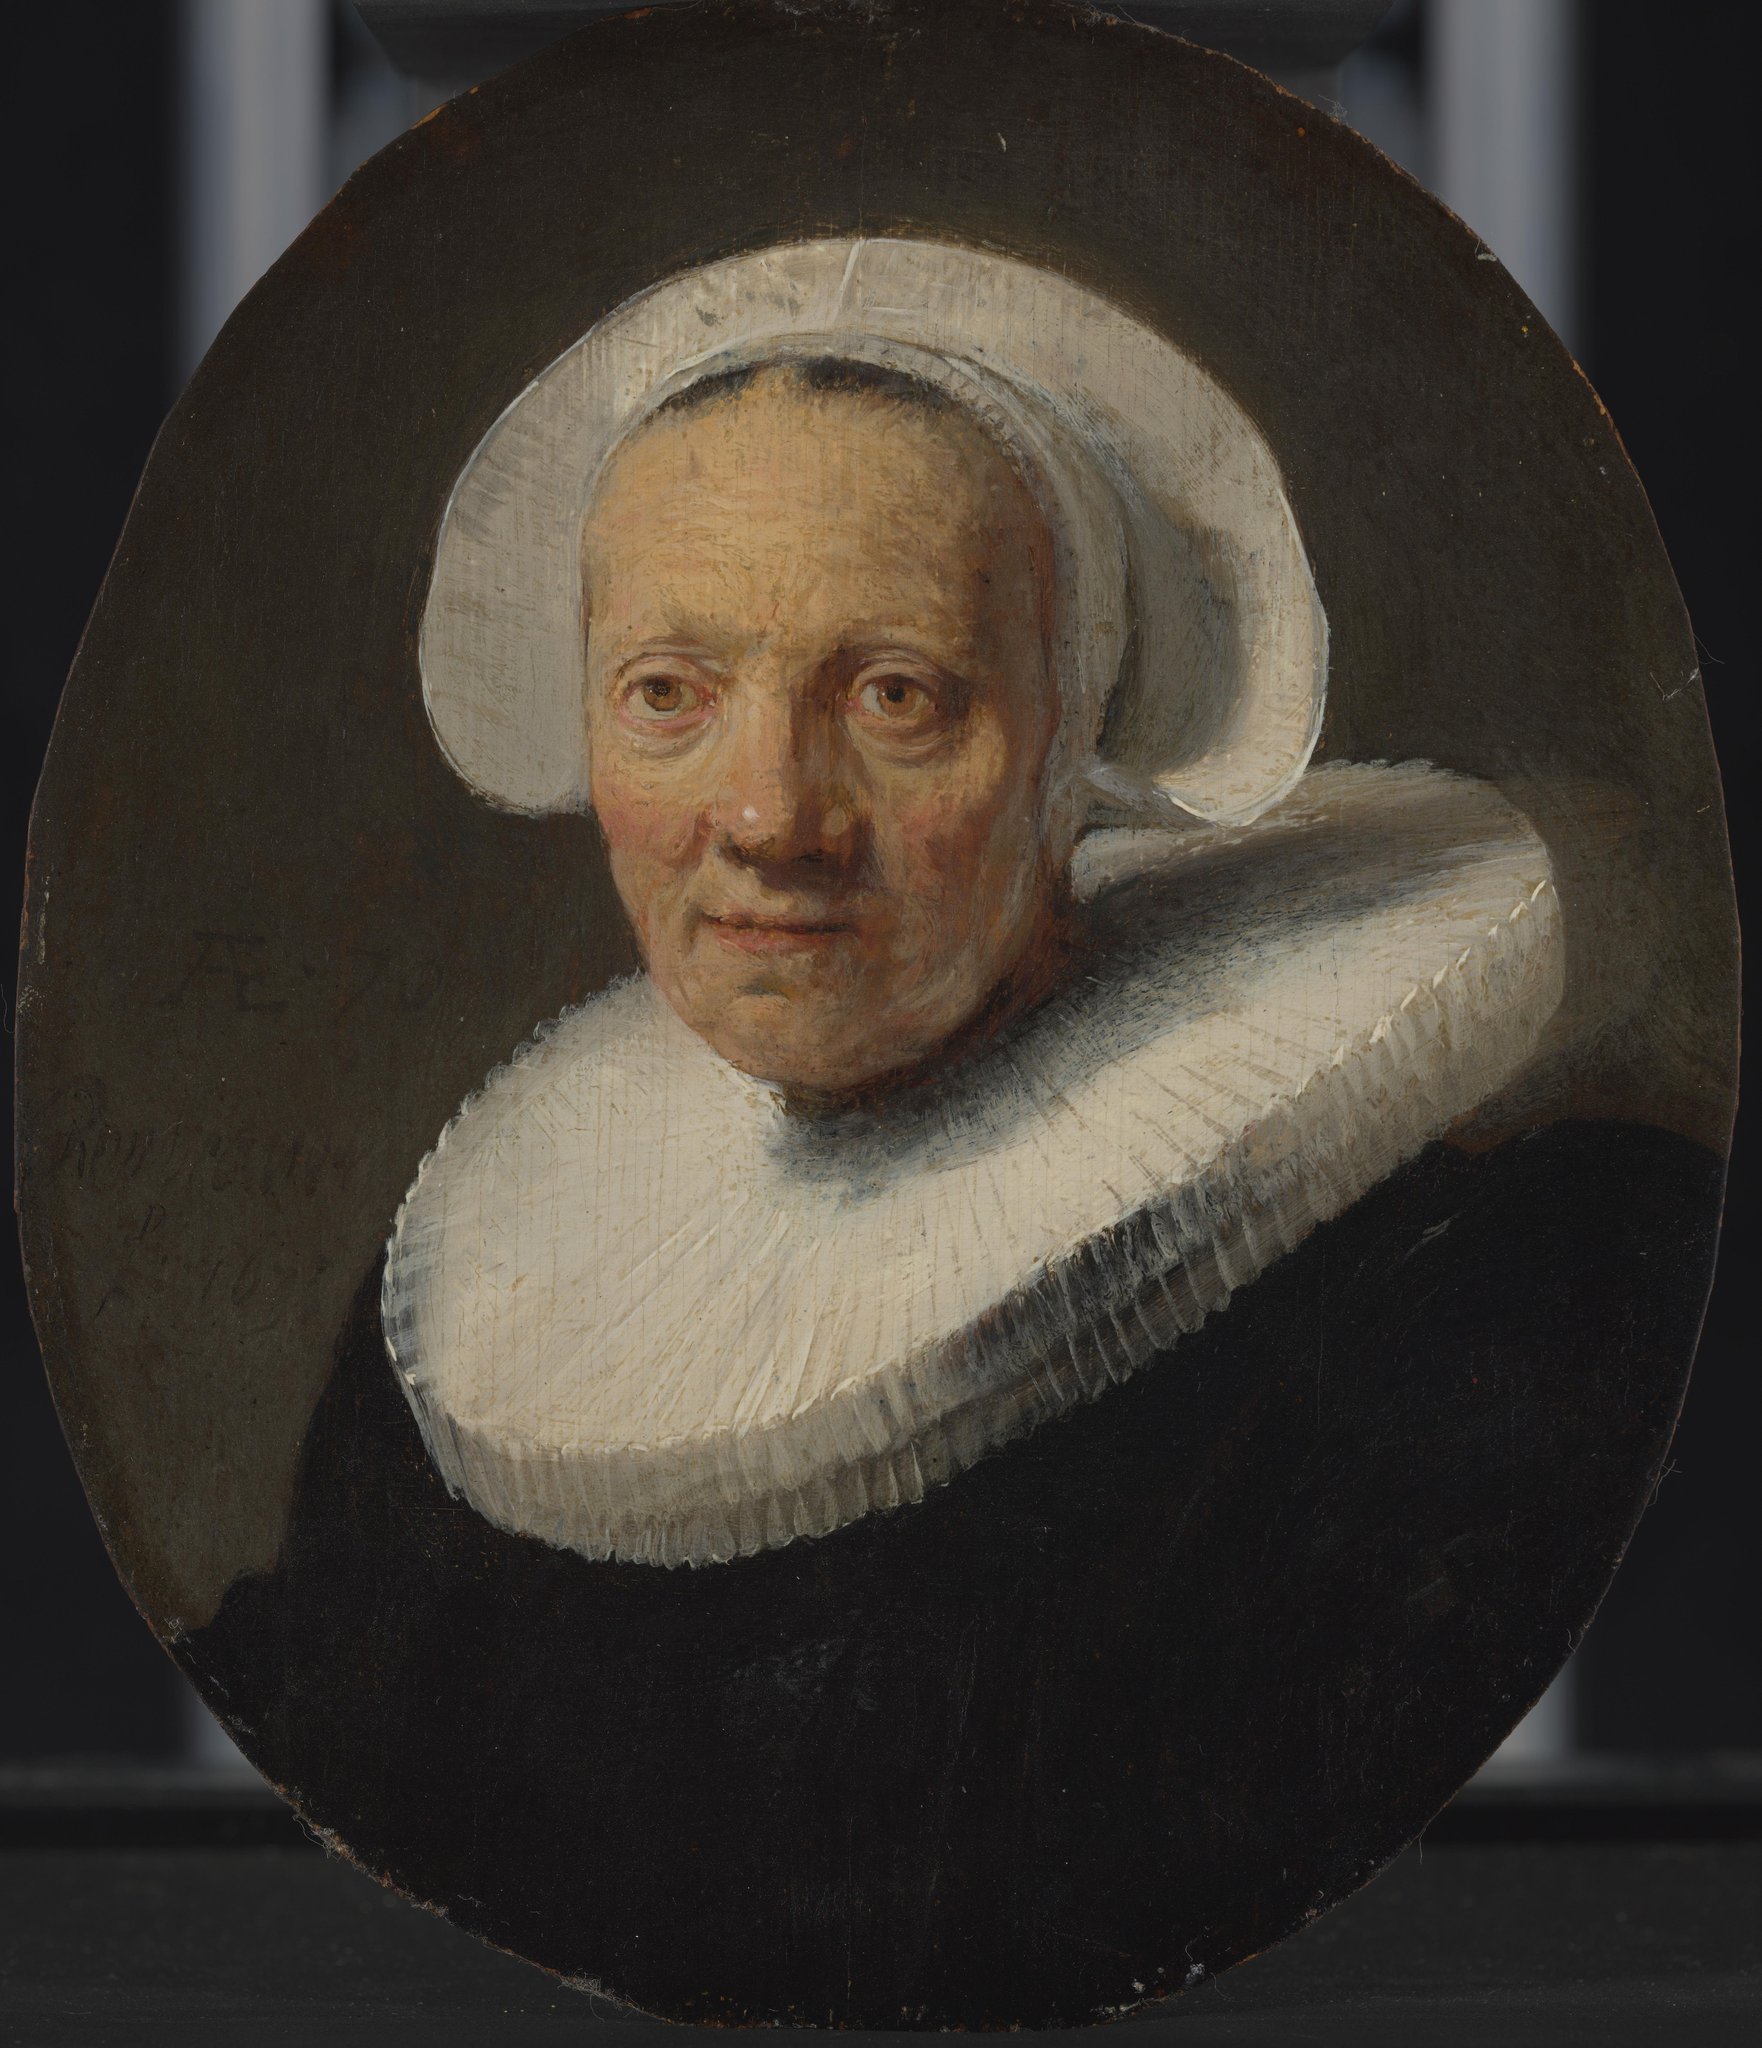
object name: painting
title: Portrait of Jaapgen Caerlsdr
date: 1635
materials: oil, paint, panel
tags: jaapgen caerlsdr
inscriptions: signature and date: ‘Æ 70 / Rembrandt / f. 1635’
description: Jaapgen Caerlsdr is 70 years old in this portrait. Hailing from a distinguished lineage, she was the daughter of a Leiden glazier. She probably sat for Rembrandt around 27 March 1635, when she served as a witness at her granddaughter’s baptism in Amsterdam. The diagonal placement of her upper body and the subtle use of shadows, for instance in the fold of the cap, contribute to her lifelike, almost three-dimensional appearance.